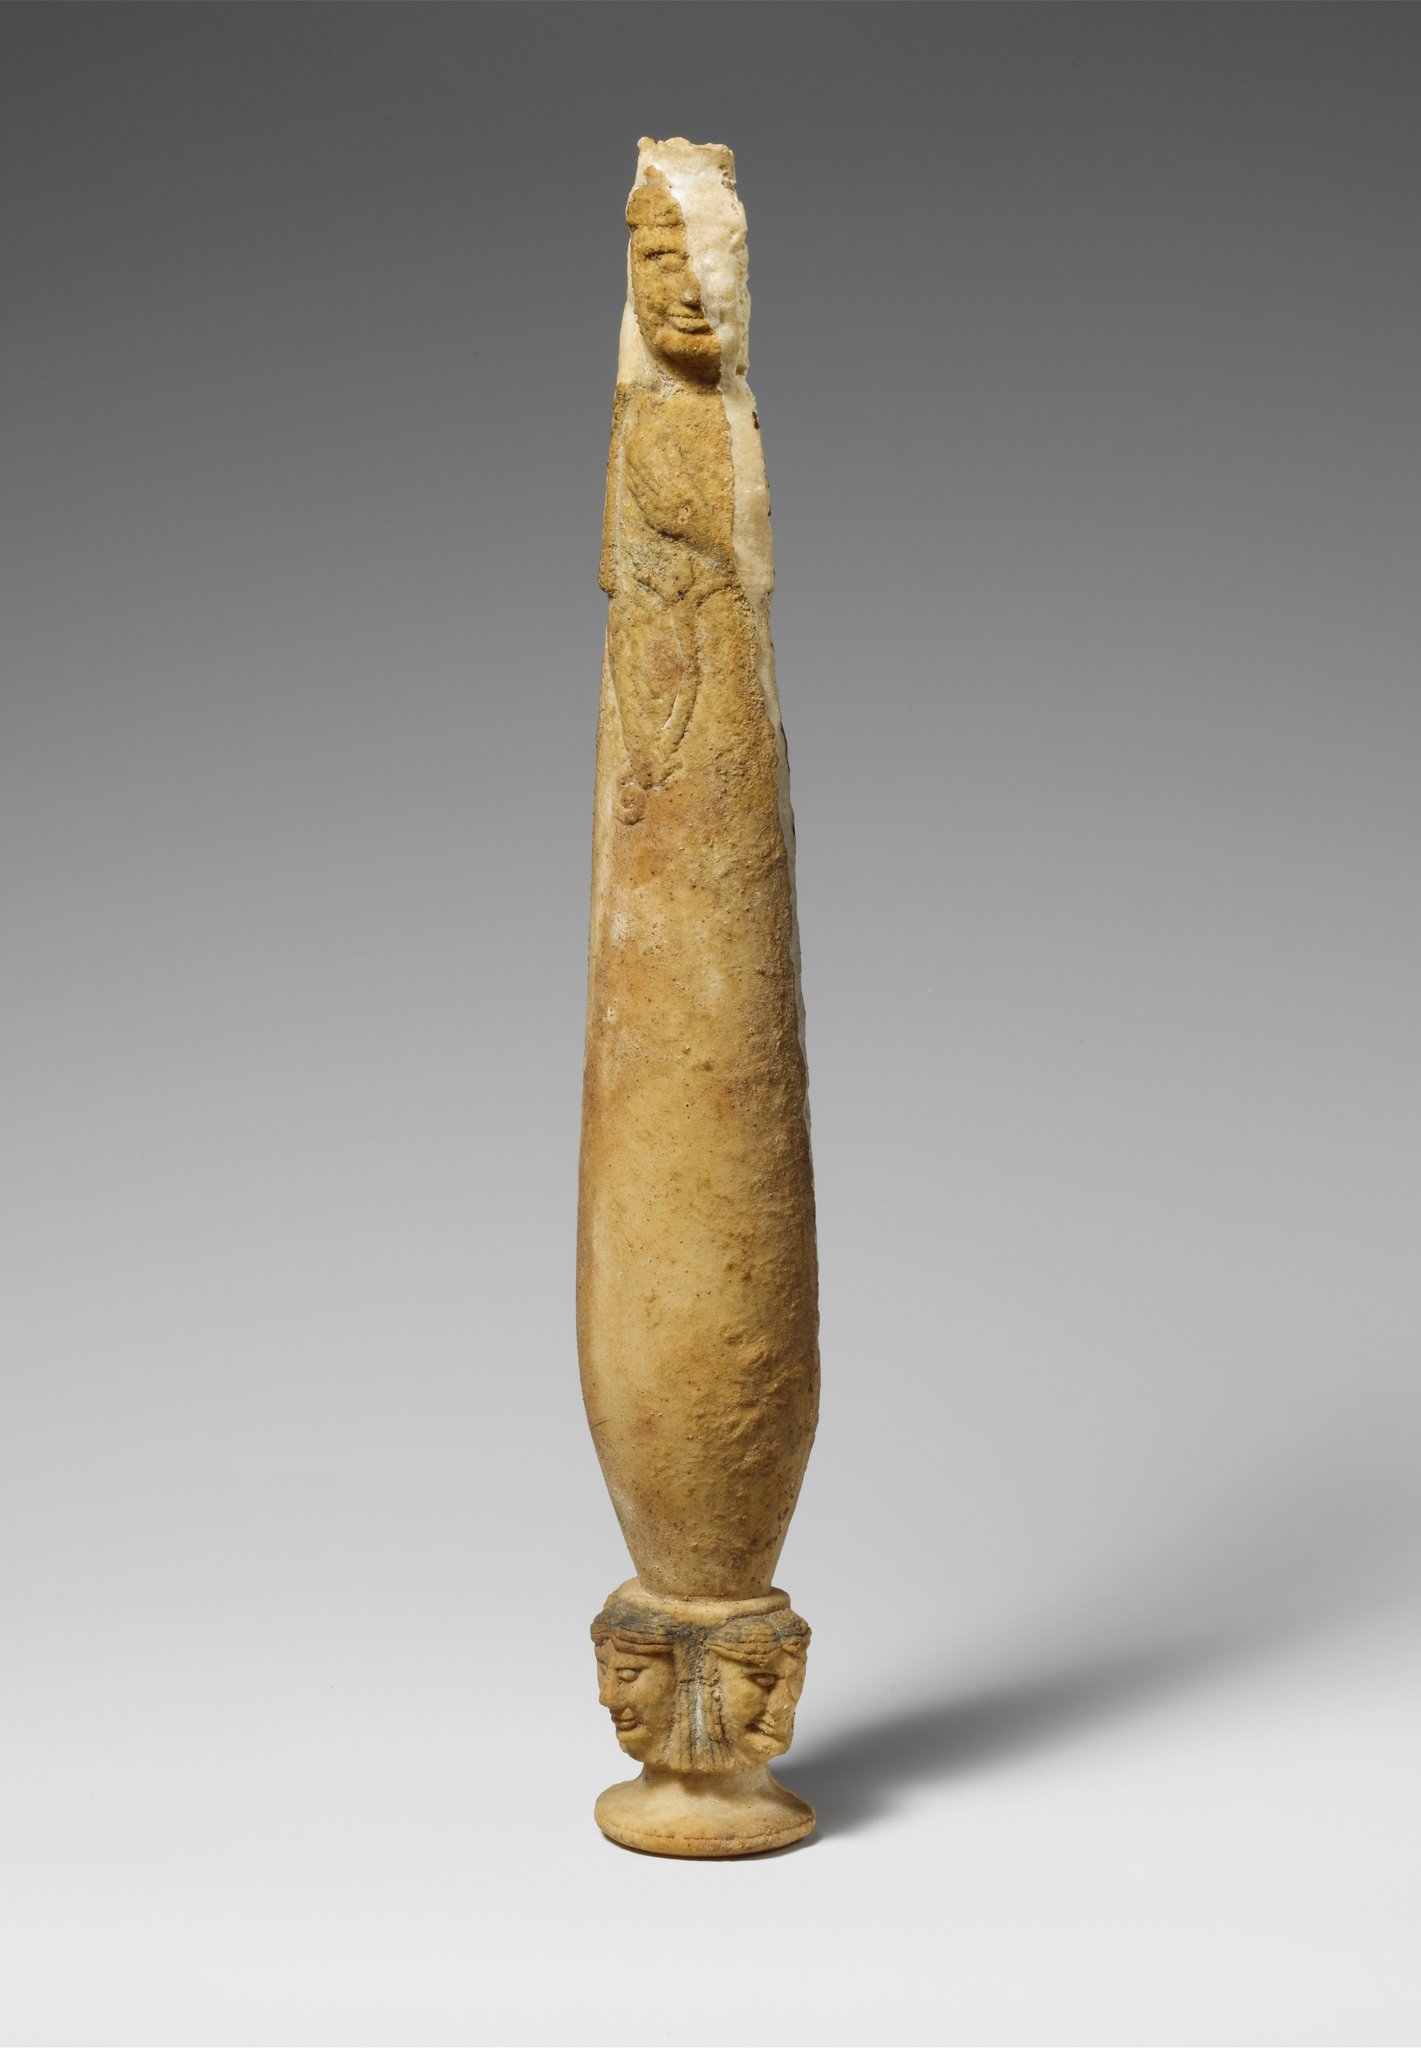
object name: alabastron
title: Alabaster alabastron (perfume vase)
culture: etruscan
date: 600-568 BCE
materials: alabaster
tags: faces